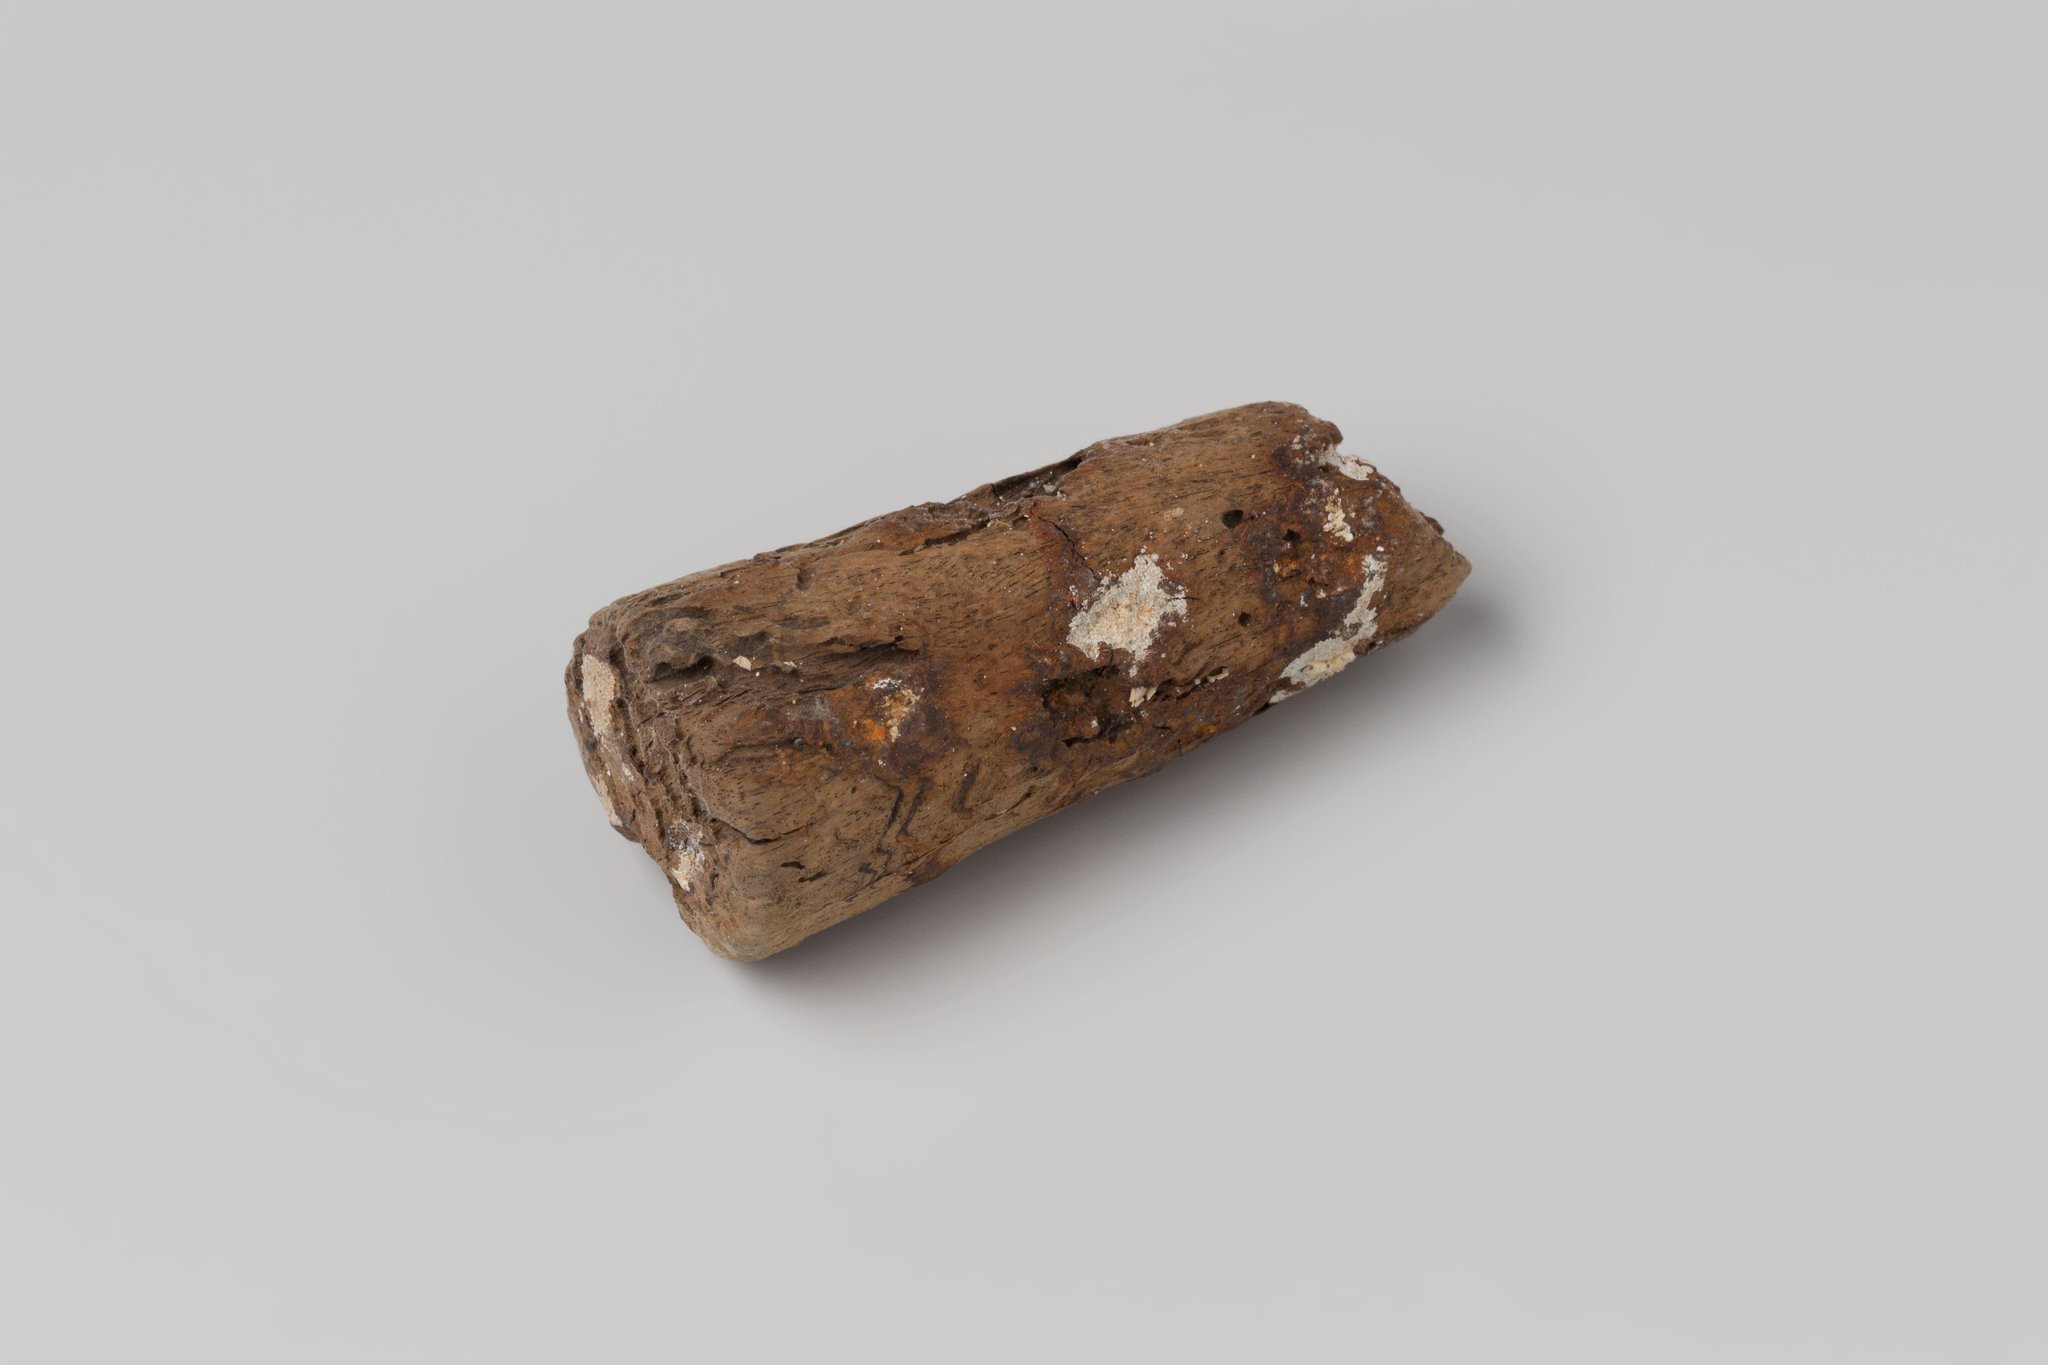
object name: fragment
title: Fragment messenheft uit het wrak van de Oost-Indiëvaarder Hollandia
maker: Anonymous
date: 1700-1743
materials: wood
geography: netherlands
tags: verenigde oostindische compagnie, hollandia (schip), annet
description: Knife, handle, cylindrical: tapering; id. NG 1979-403H.